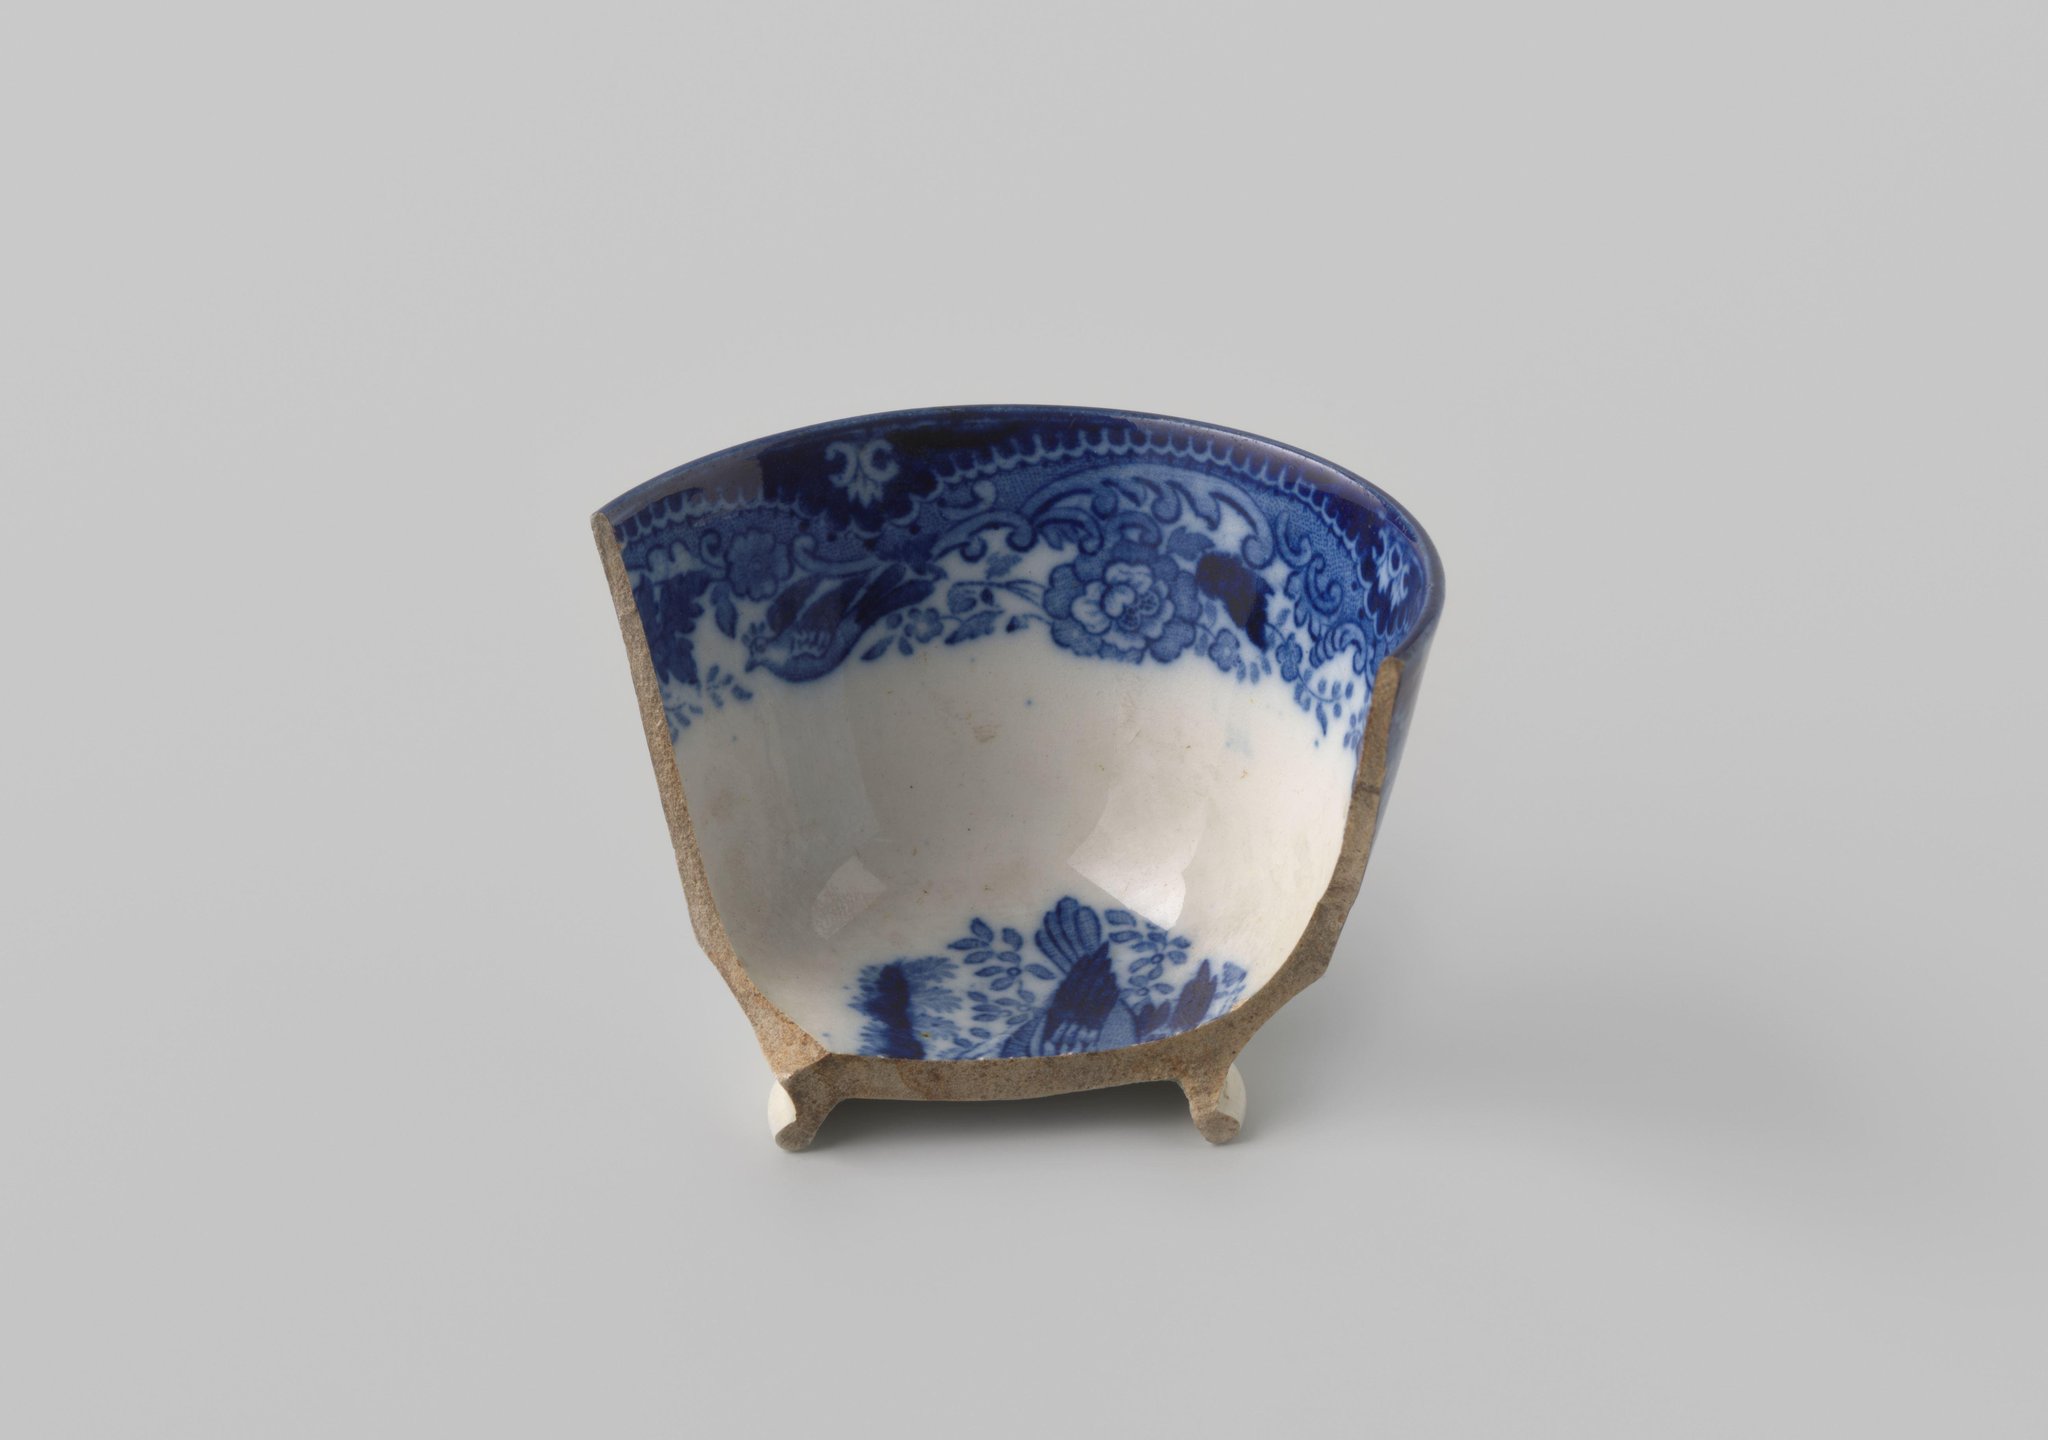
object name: fragment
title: Fragment van een kom van witbakkend aardewerk, met aan de binnen- en buitenzijde een drukdecor met bloemen in blauw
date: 1500-1899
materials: earthenware, glaze